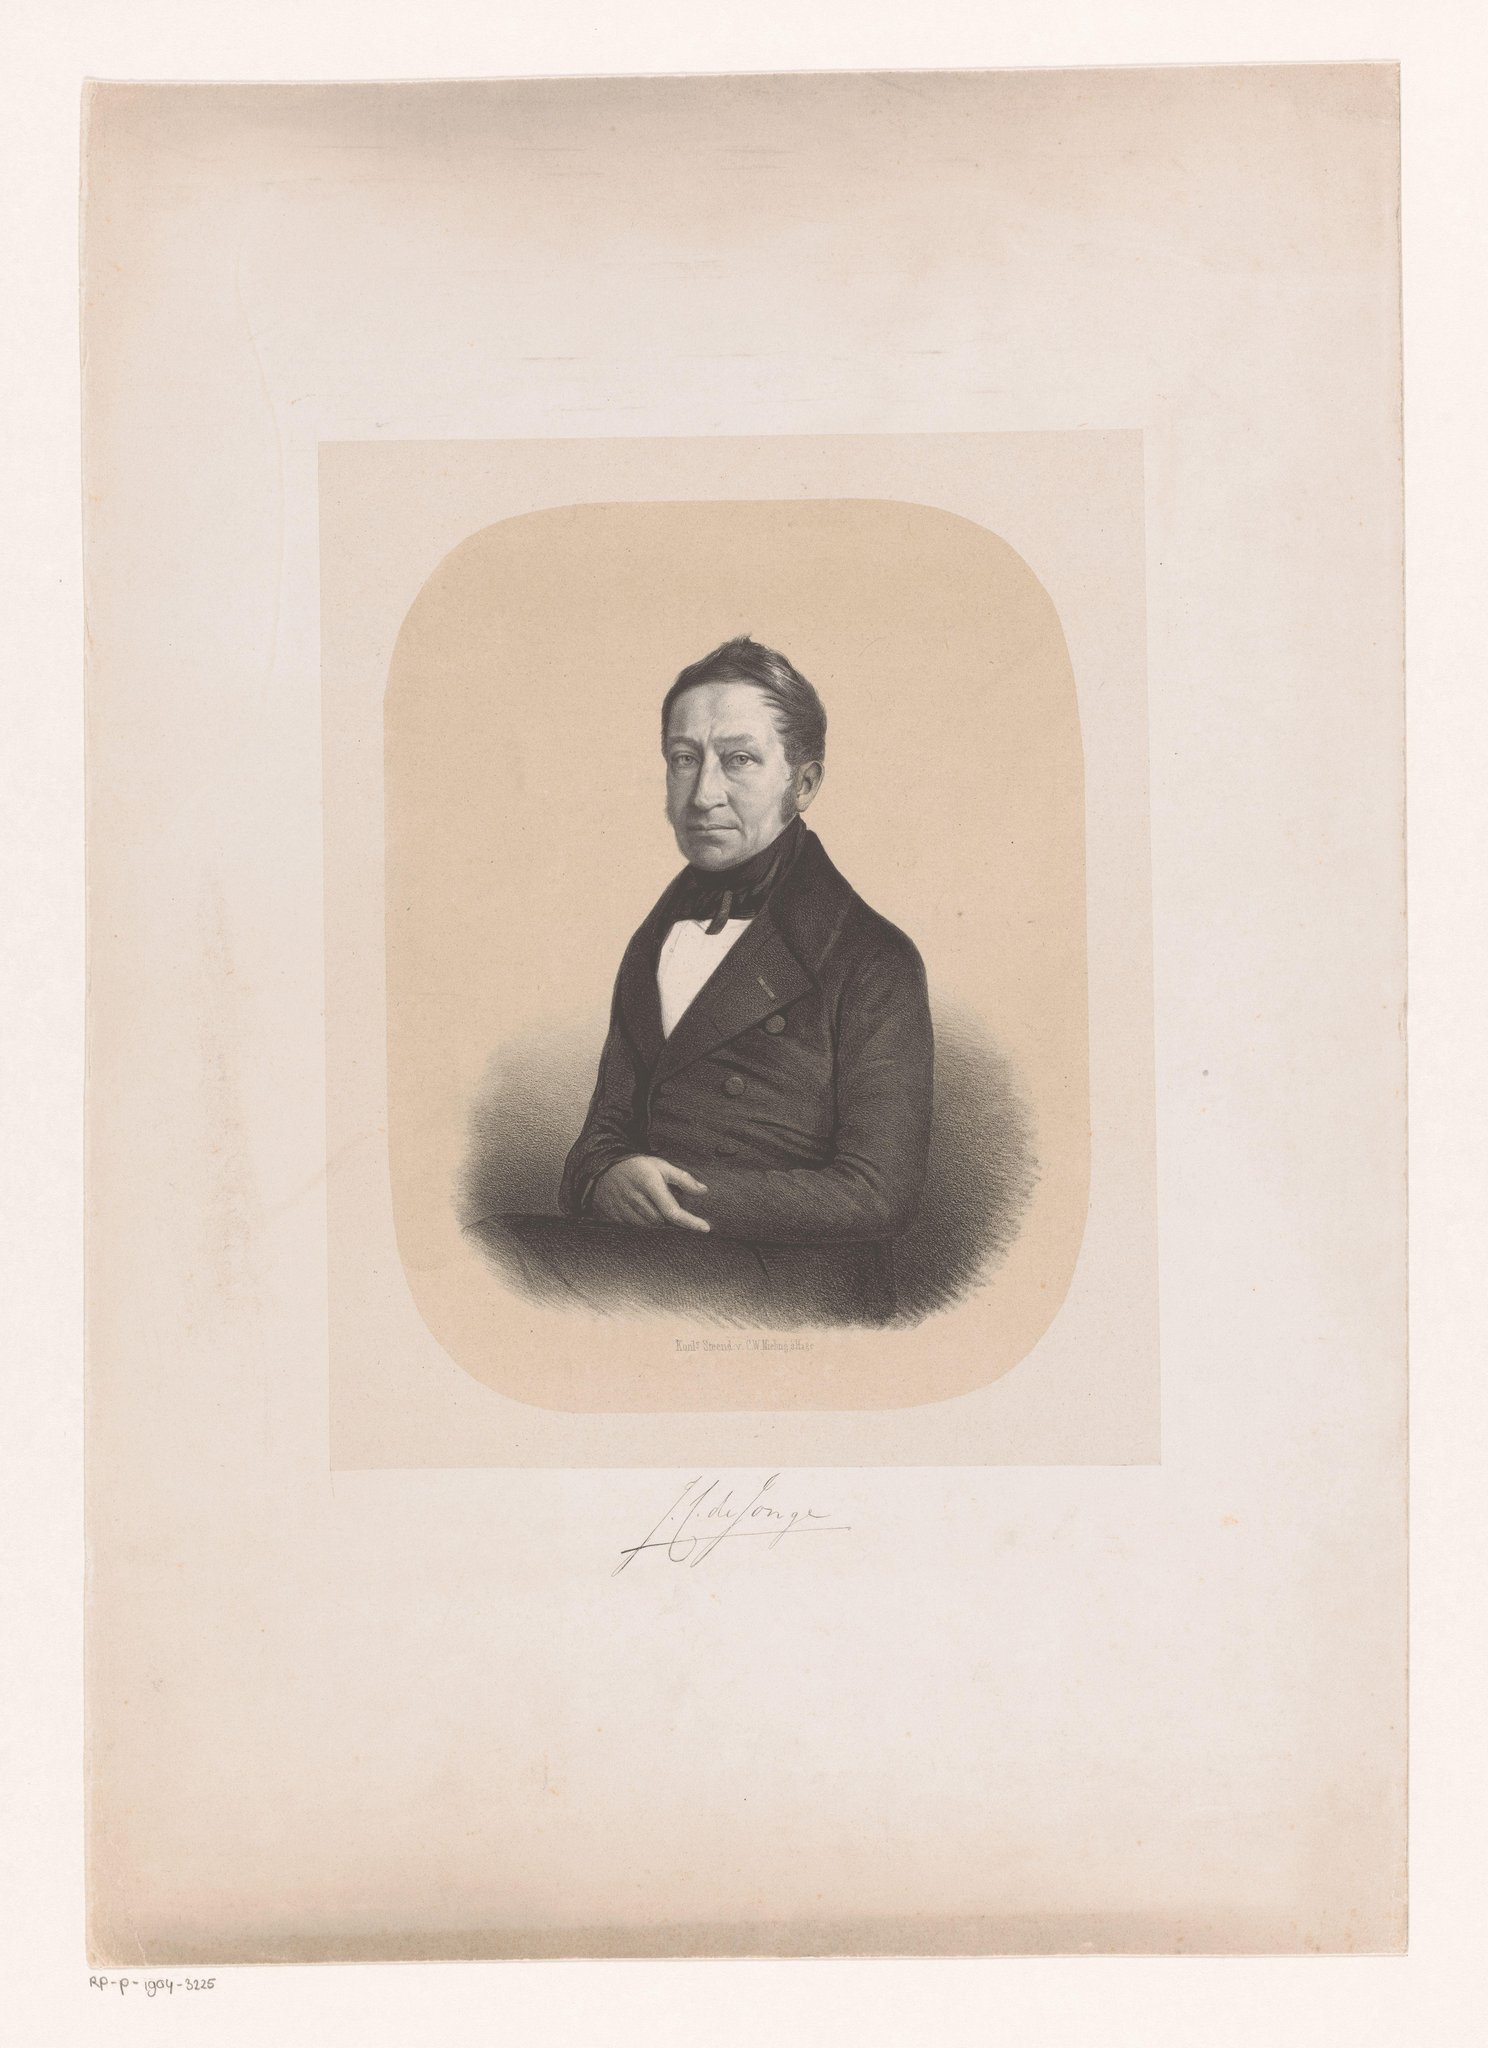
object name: print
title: Portret van Johannes Cornelis de Jonge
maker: Anonymous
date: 1847-1865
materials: paper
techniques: tone lithography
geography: the hague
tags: johannes cornelis jonge, historical persons (+ three-quarter length portrait)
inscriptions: collector's mark: Lugt 2228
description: Onder het portret de signatuur van de geportretteerde.